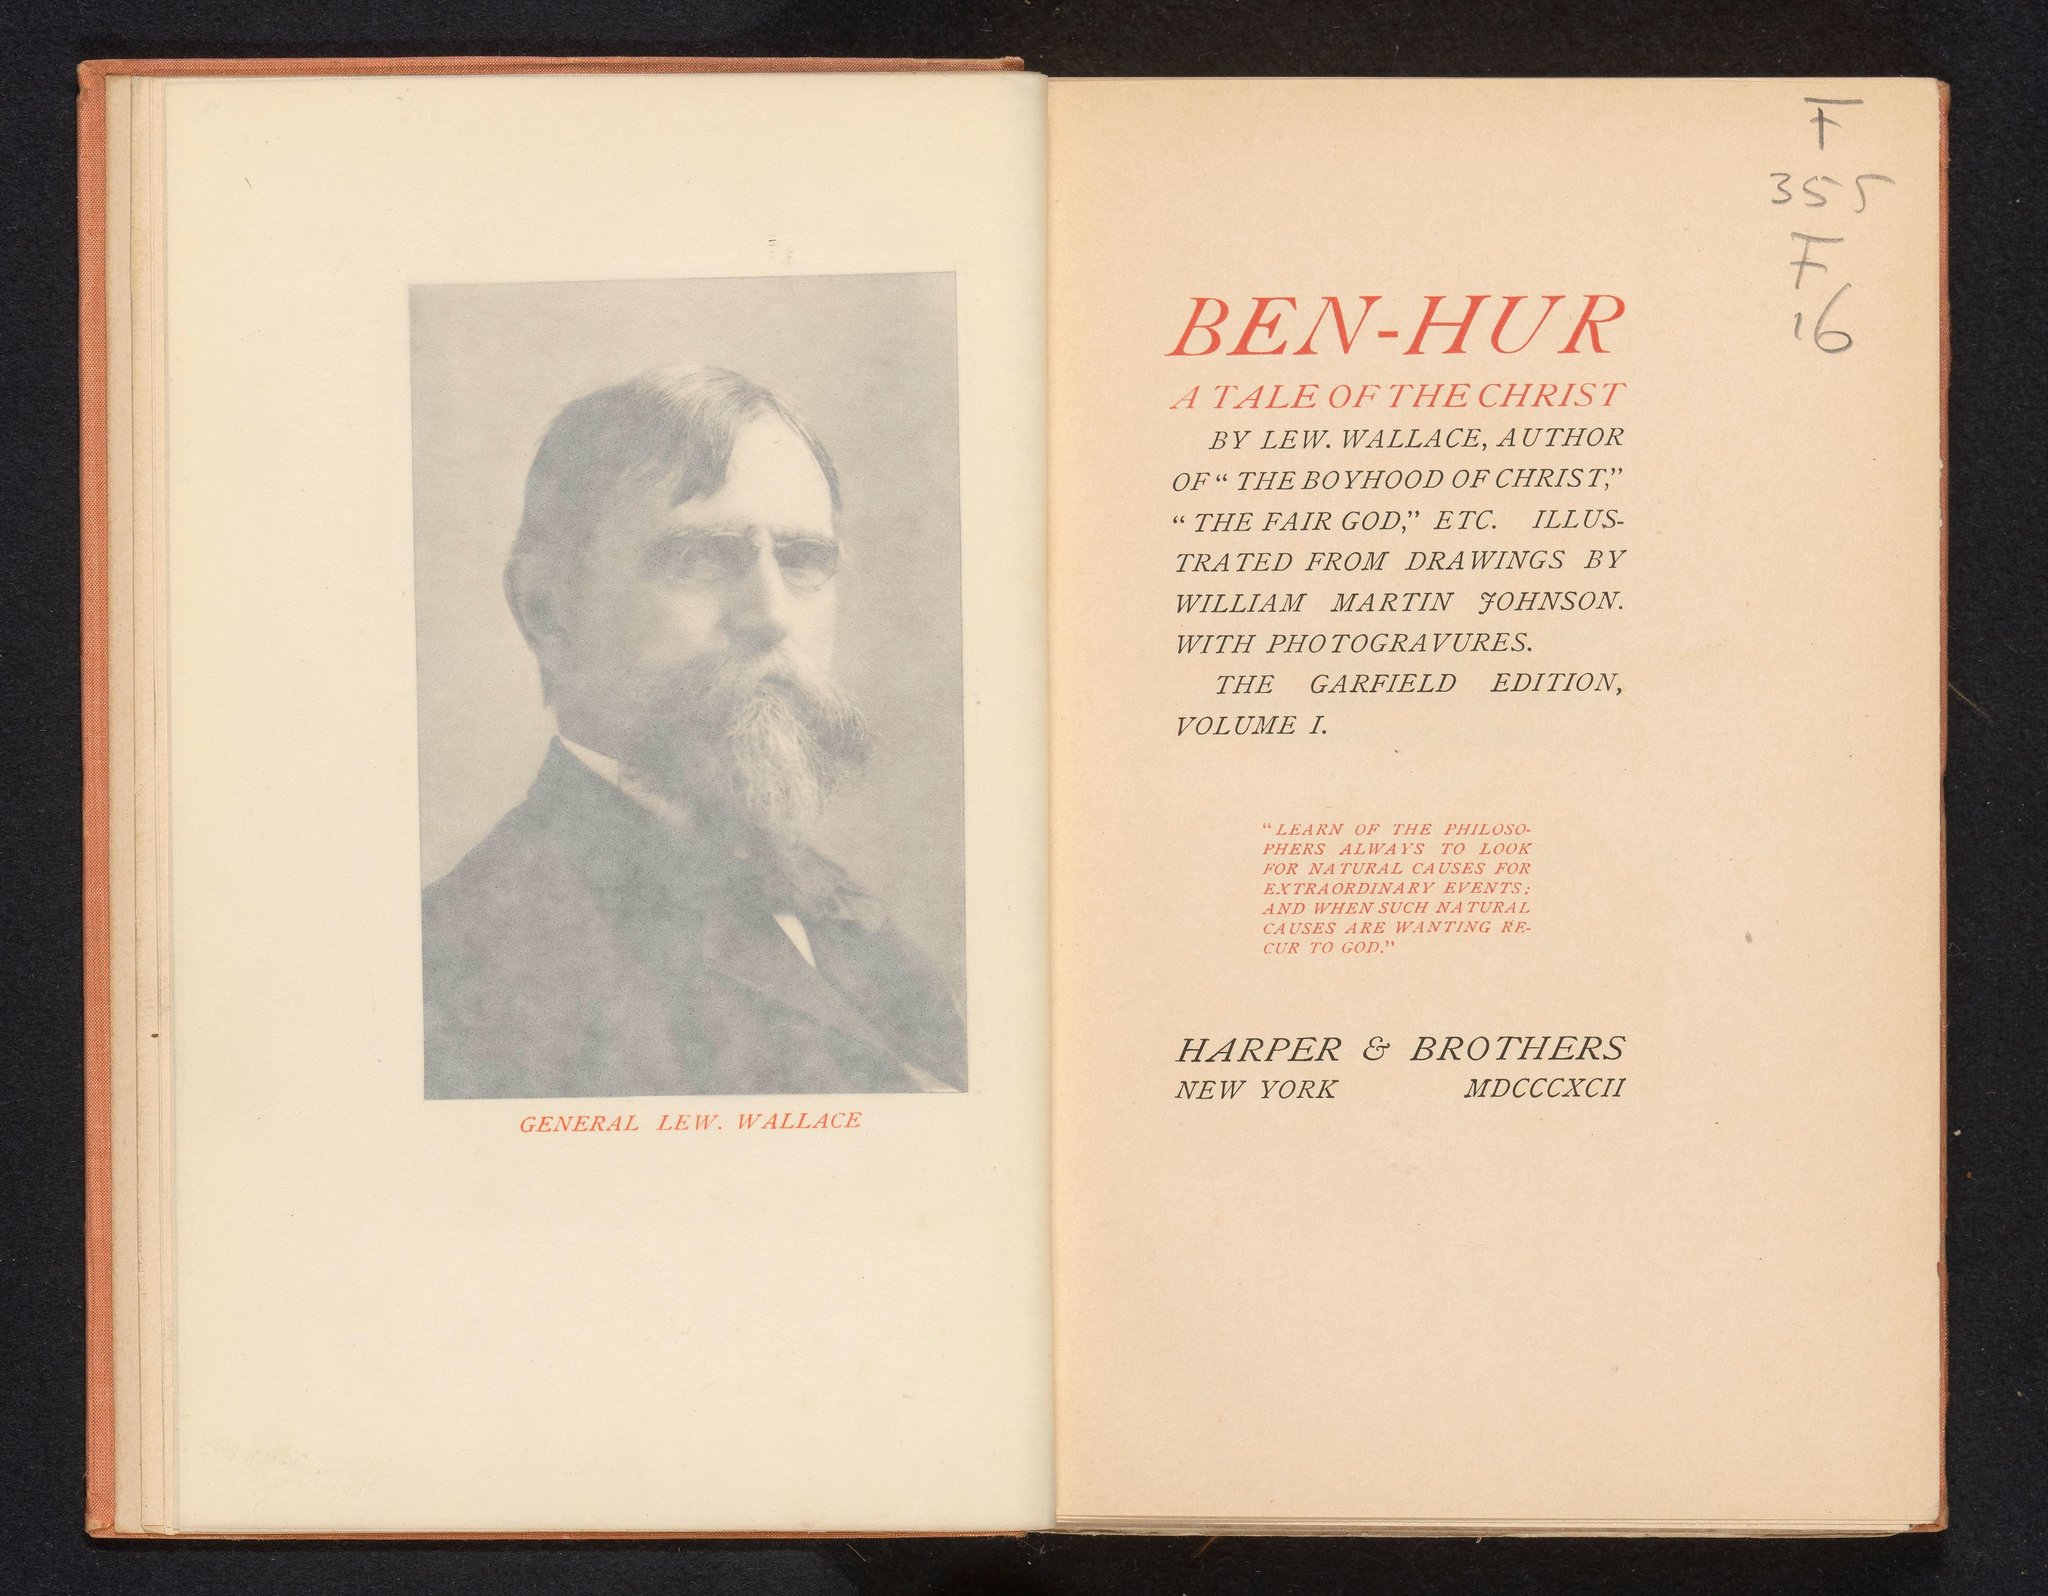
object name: book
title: Ben-Hur a tale of the Christ Volume I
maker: lewis wallace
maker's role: schrijver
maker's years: 1827-1905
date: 1892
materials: linen, paper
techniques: photoaquatint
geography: new york city